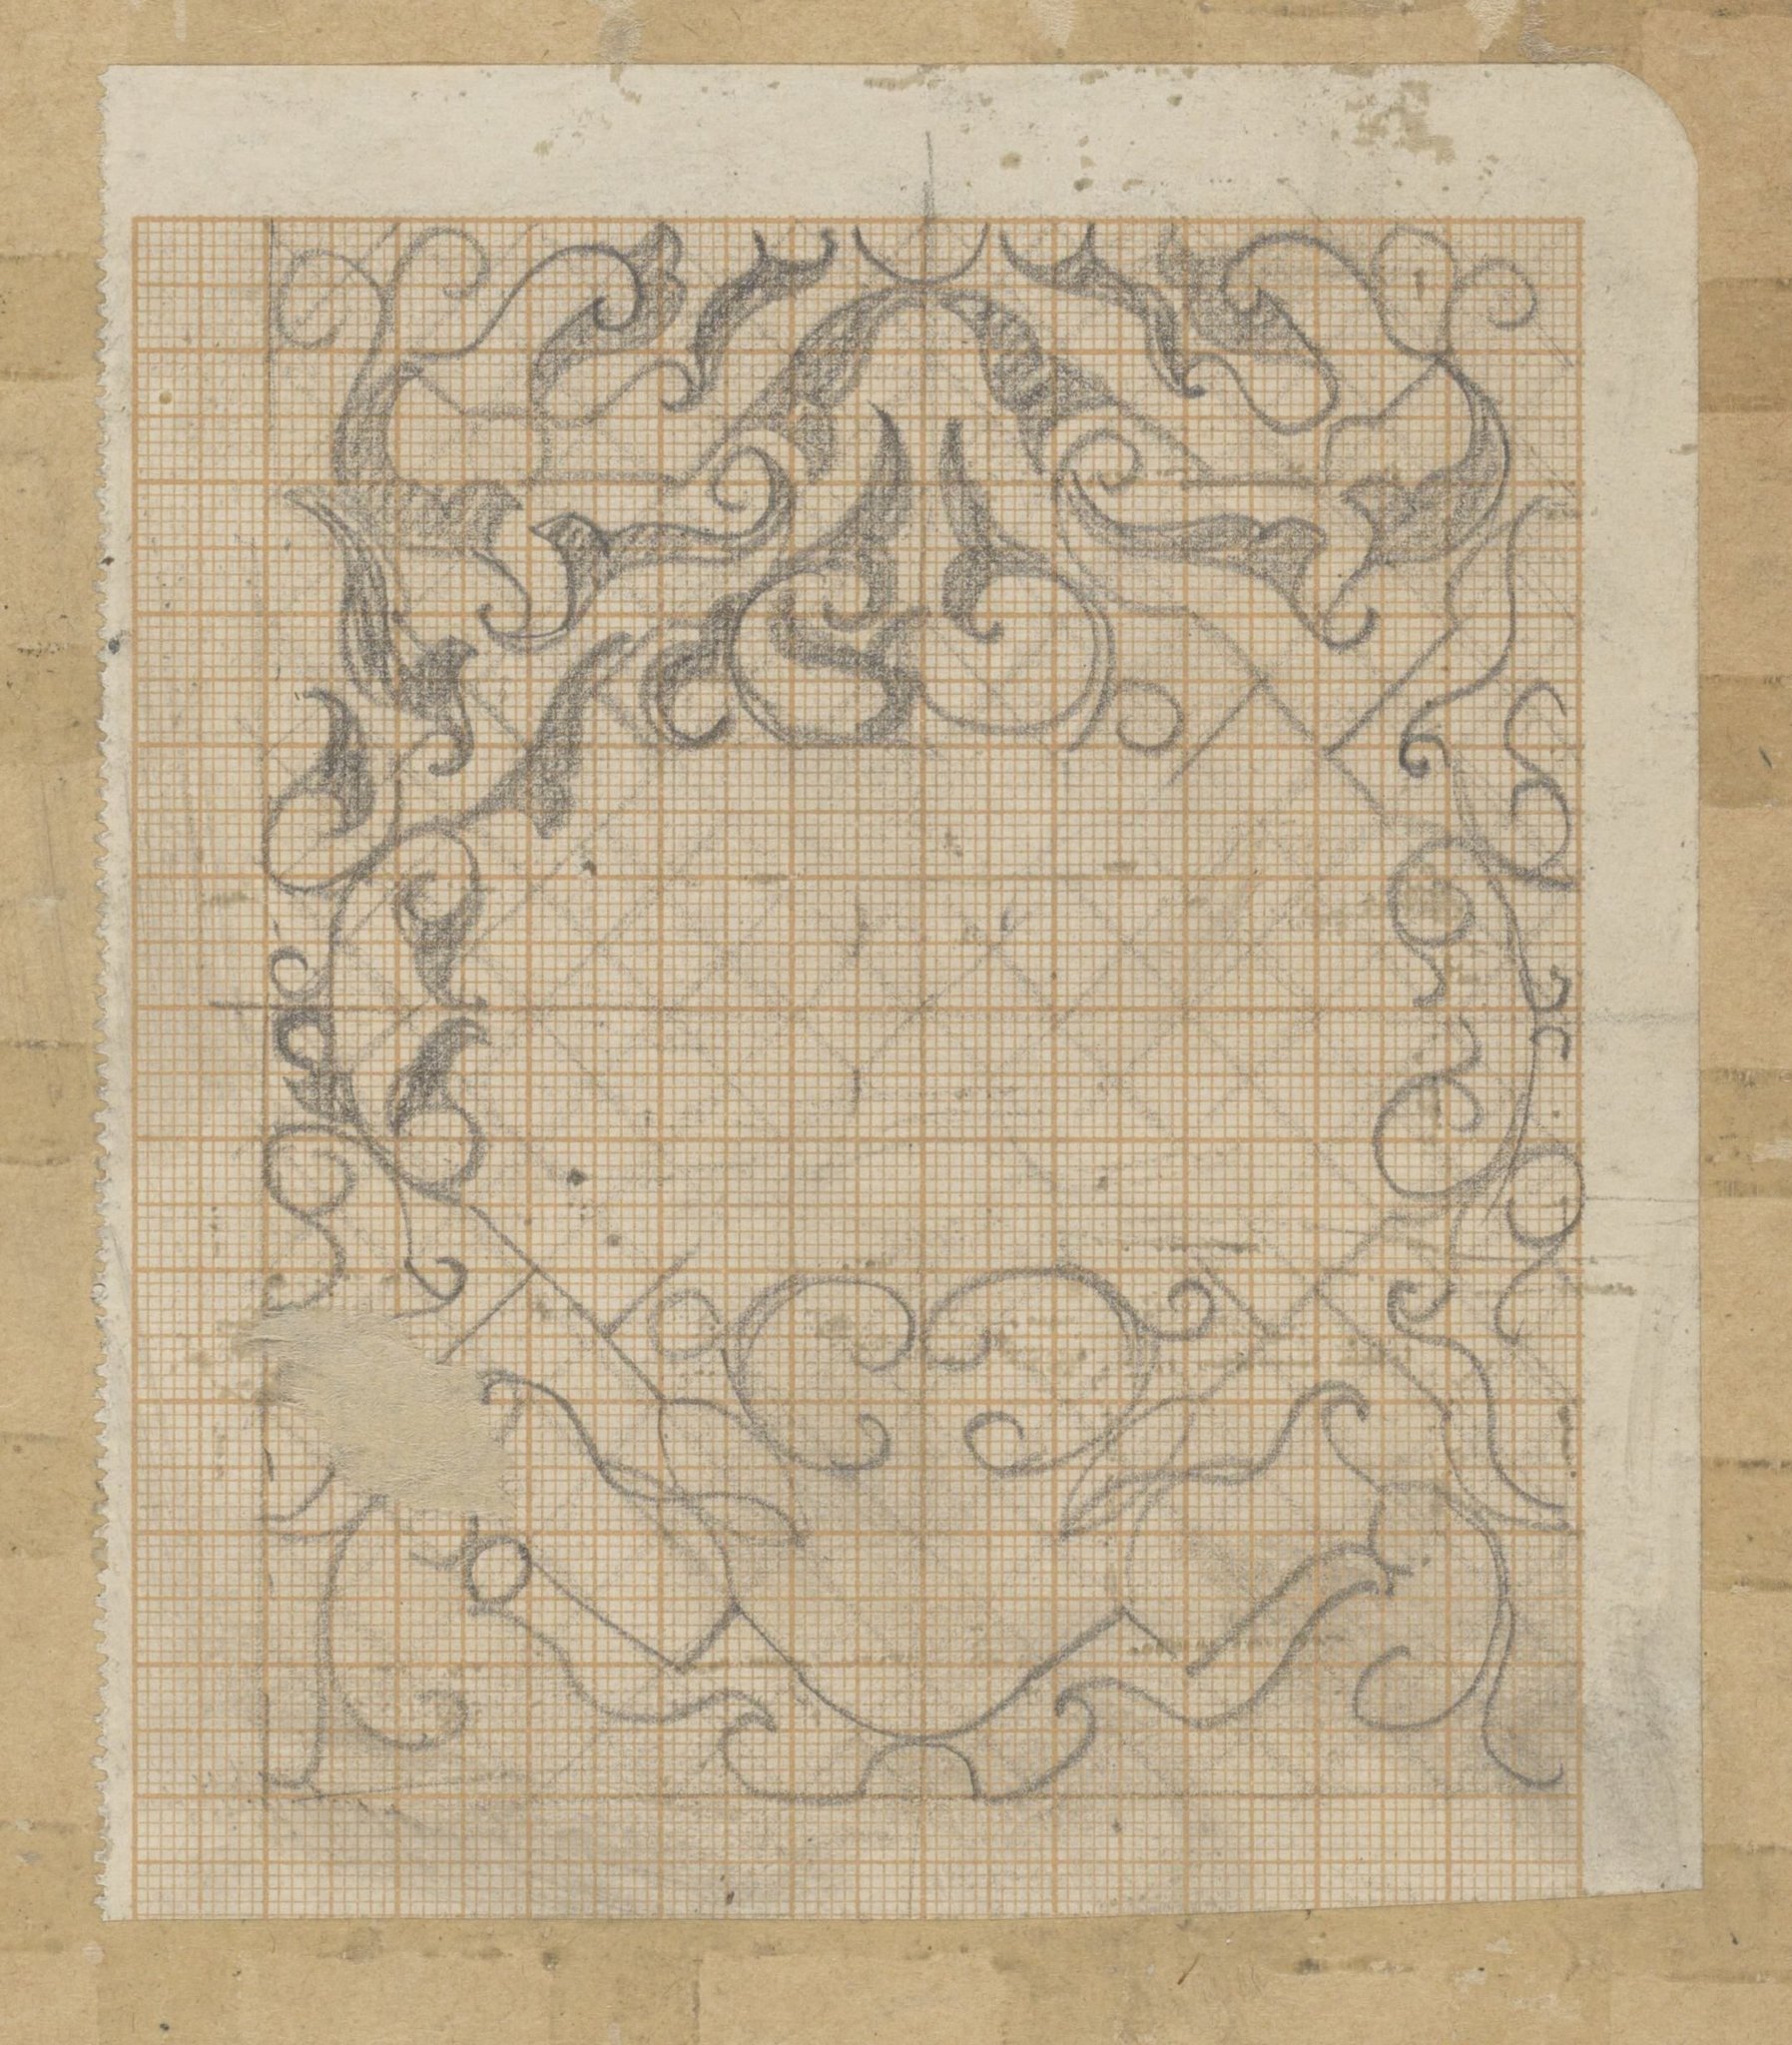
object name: drawing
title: Decoratief ontwerp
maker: carel adolph lion cachet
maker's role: draughtsman, print maker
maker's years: 1864-1945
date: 1874-1945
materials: pencil